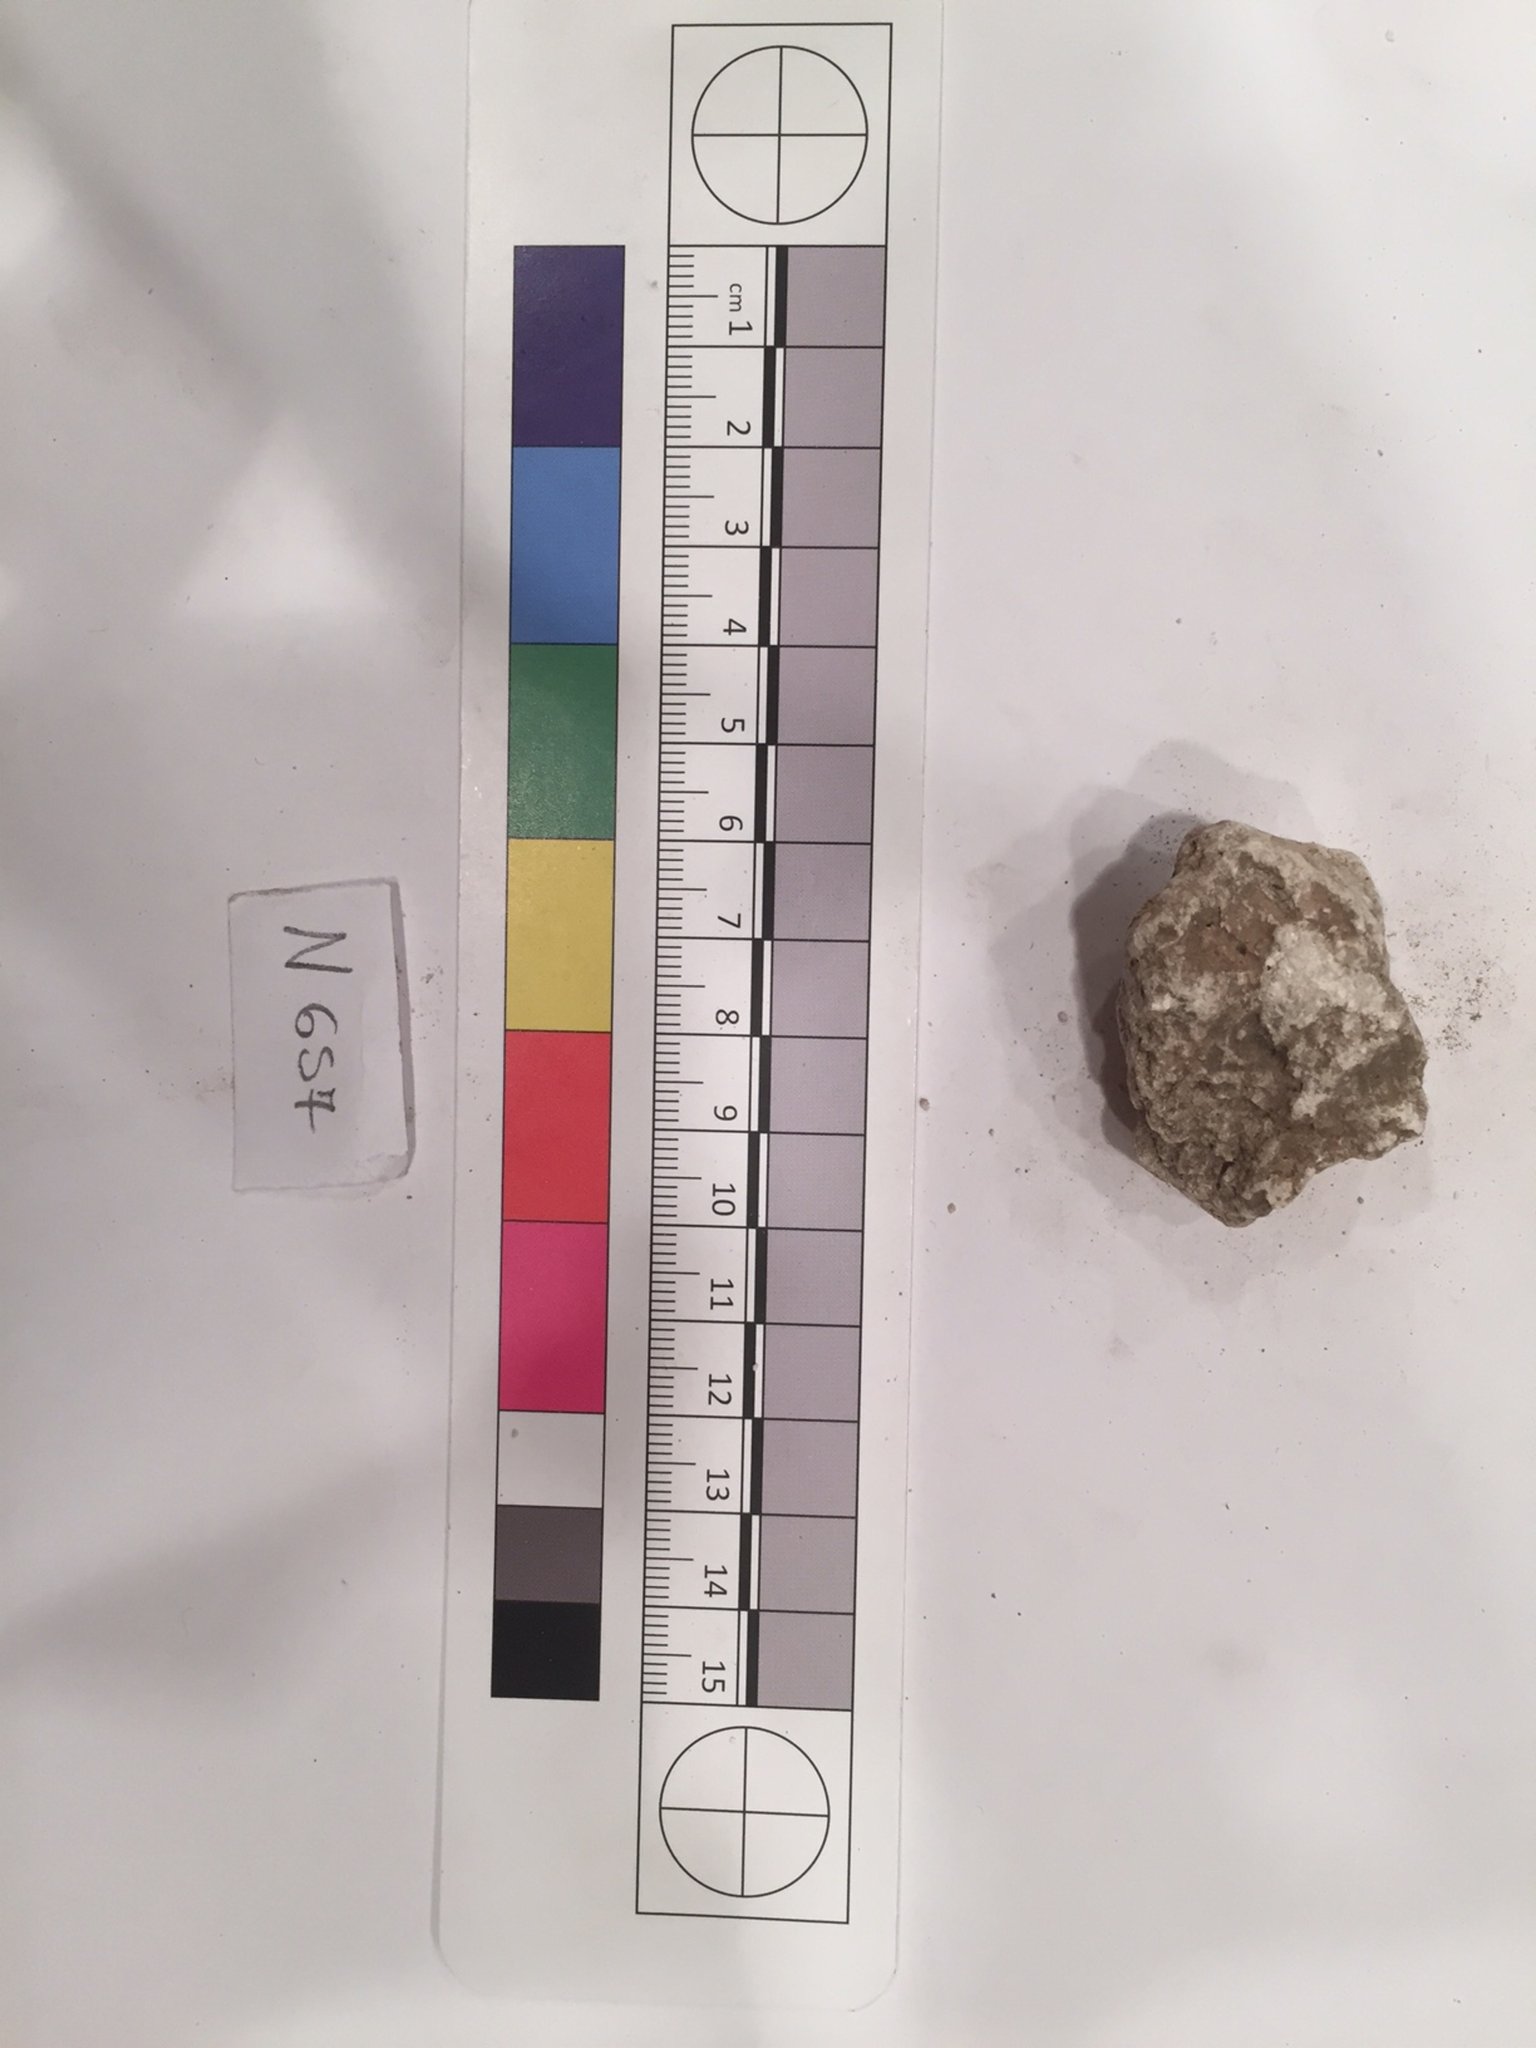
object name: fragment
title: Stucco Fragment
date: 701-1200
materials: plaster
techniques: carving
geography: iran